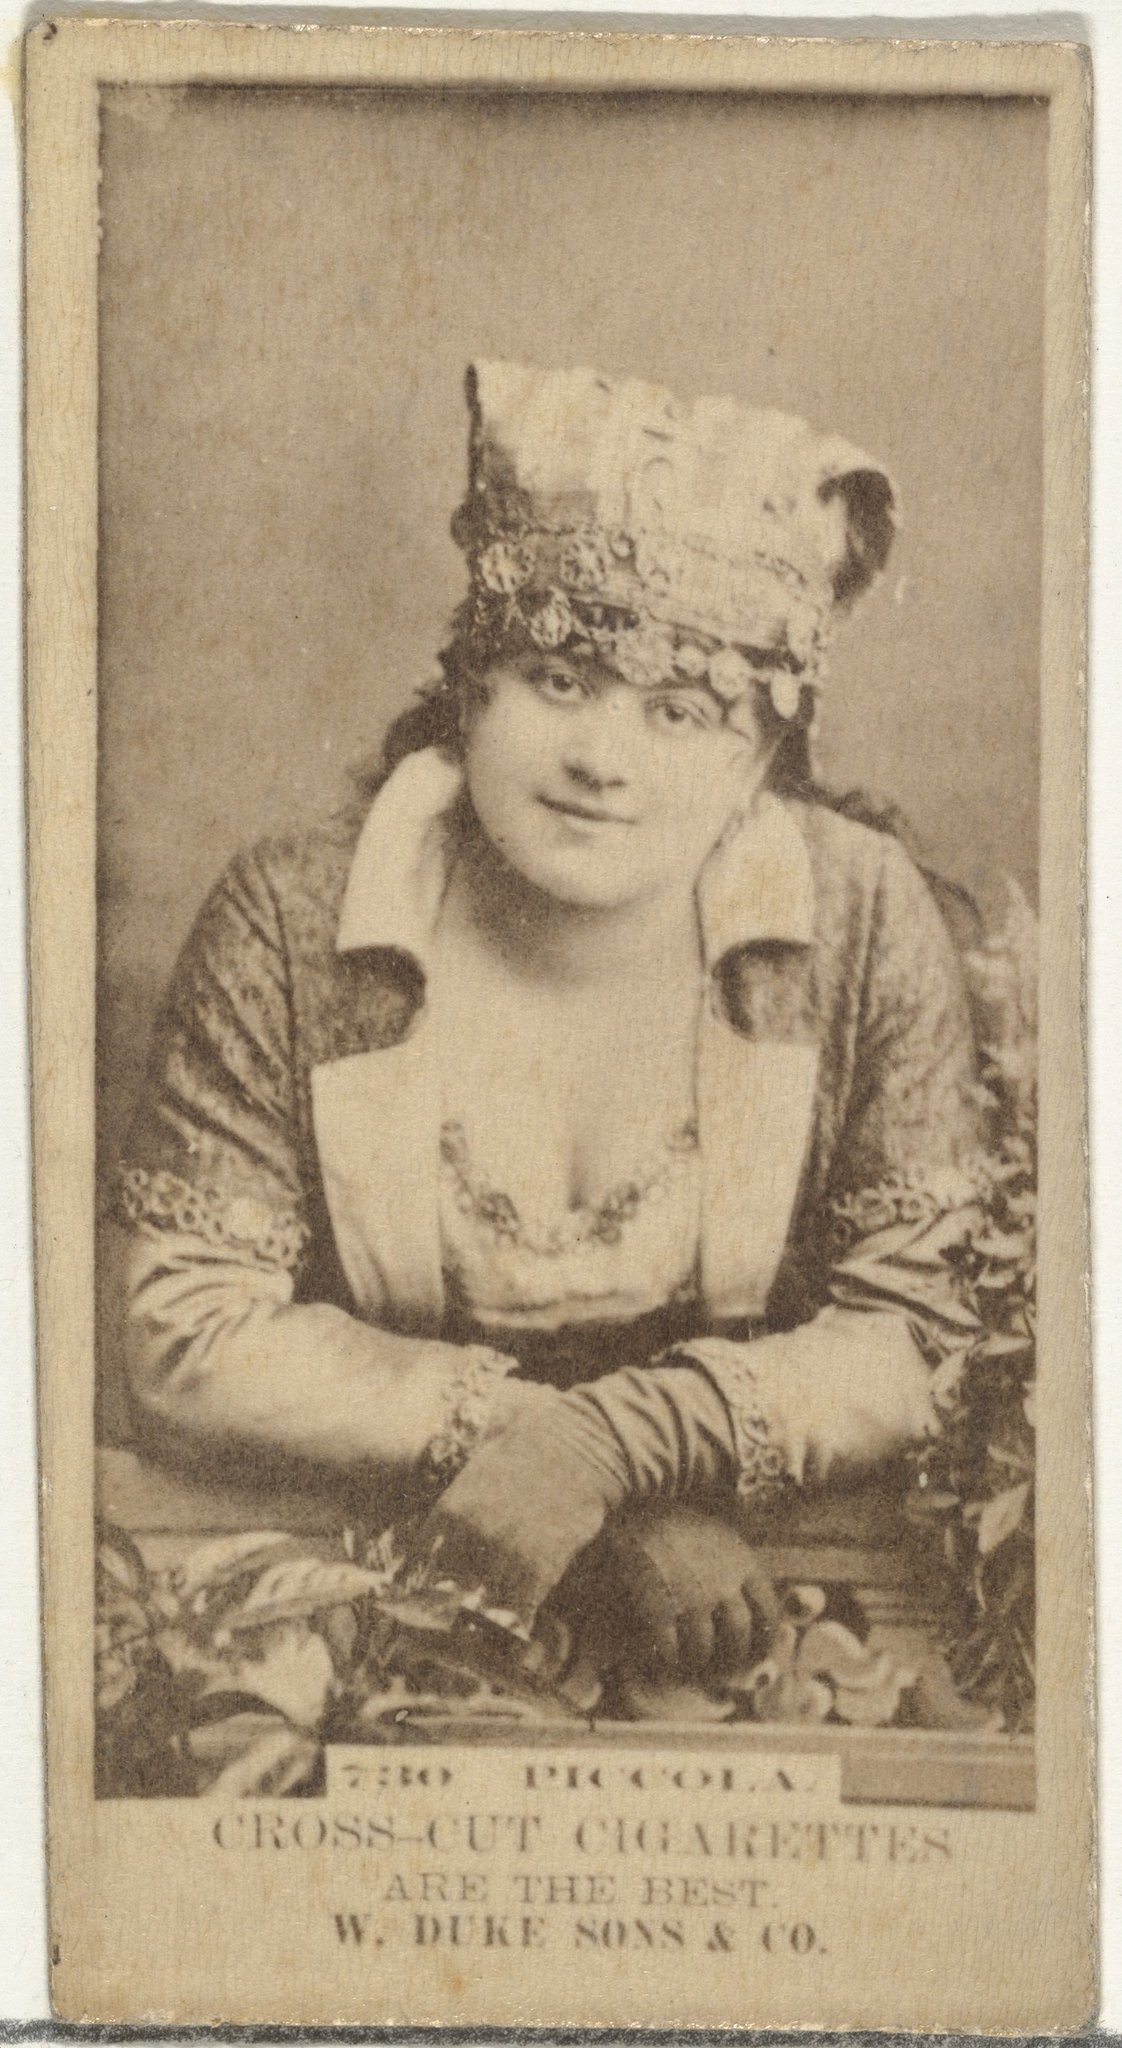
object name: photograph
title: Card Number 730, Piccola, from the Actors and Actresses series (N145-3) issued by Duke Sons & Co. to promote Cross Cut Cigarettes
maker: w. duke, sons & co.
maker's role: publisher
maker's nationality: american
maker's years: 1870-1920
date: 1880-1889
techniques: albumen silver print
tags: portraits,women,actresses